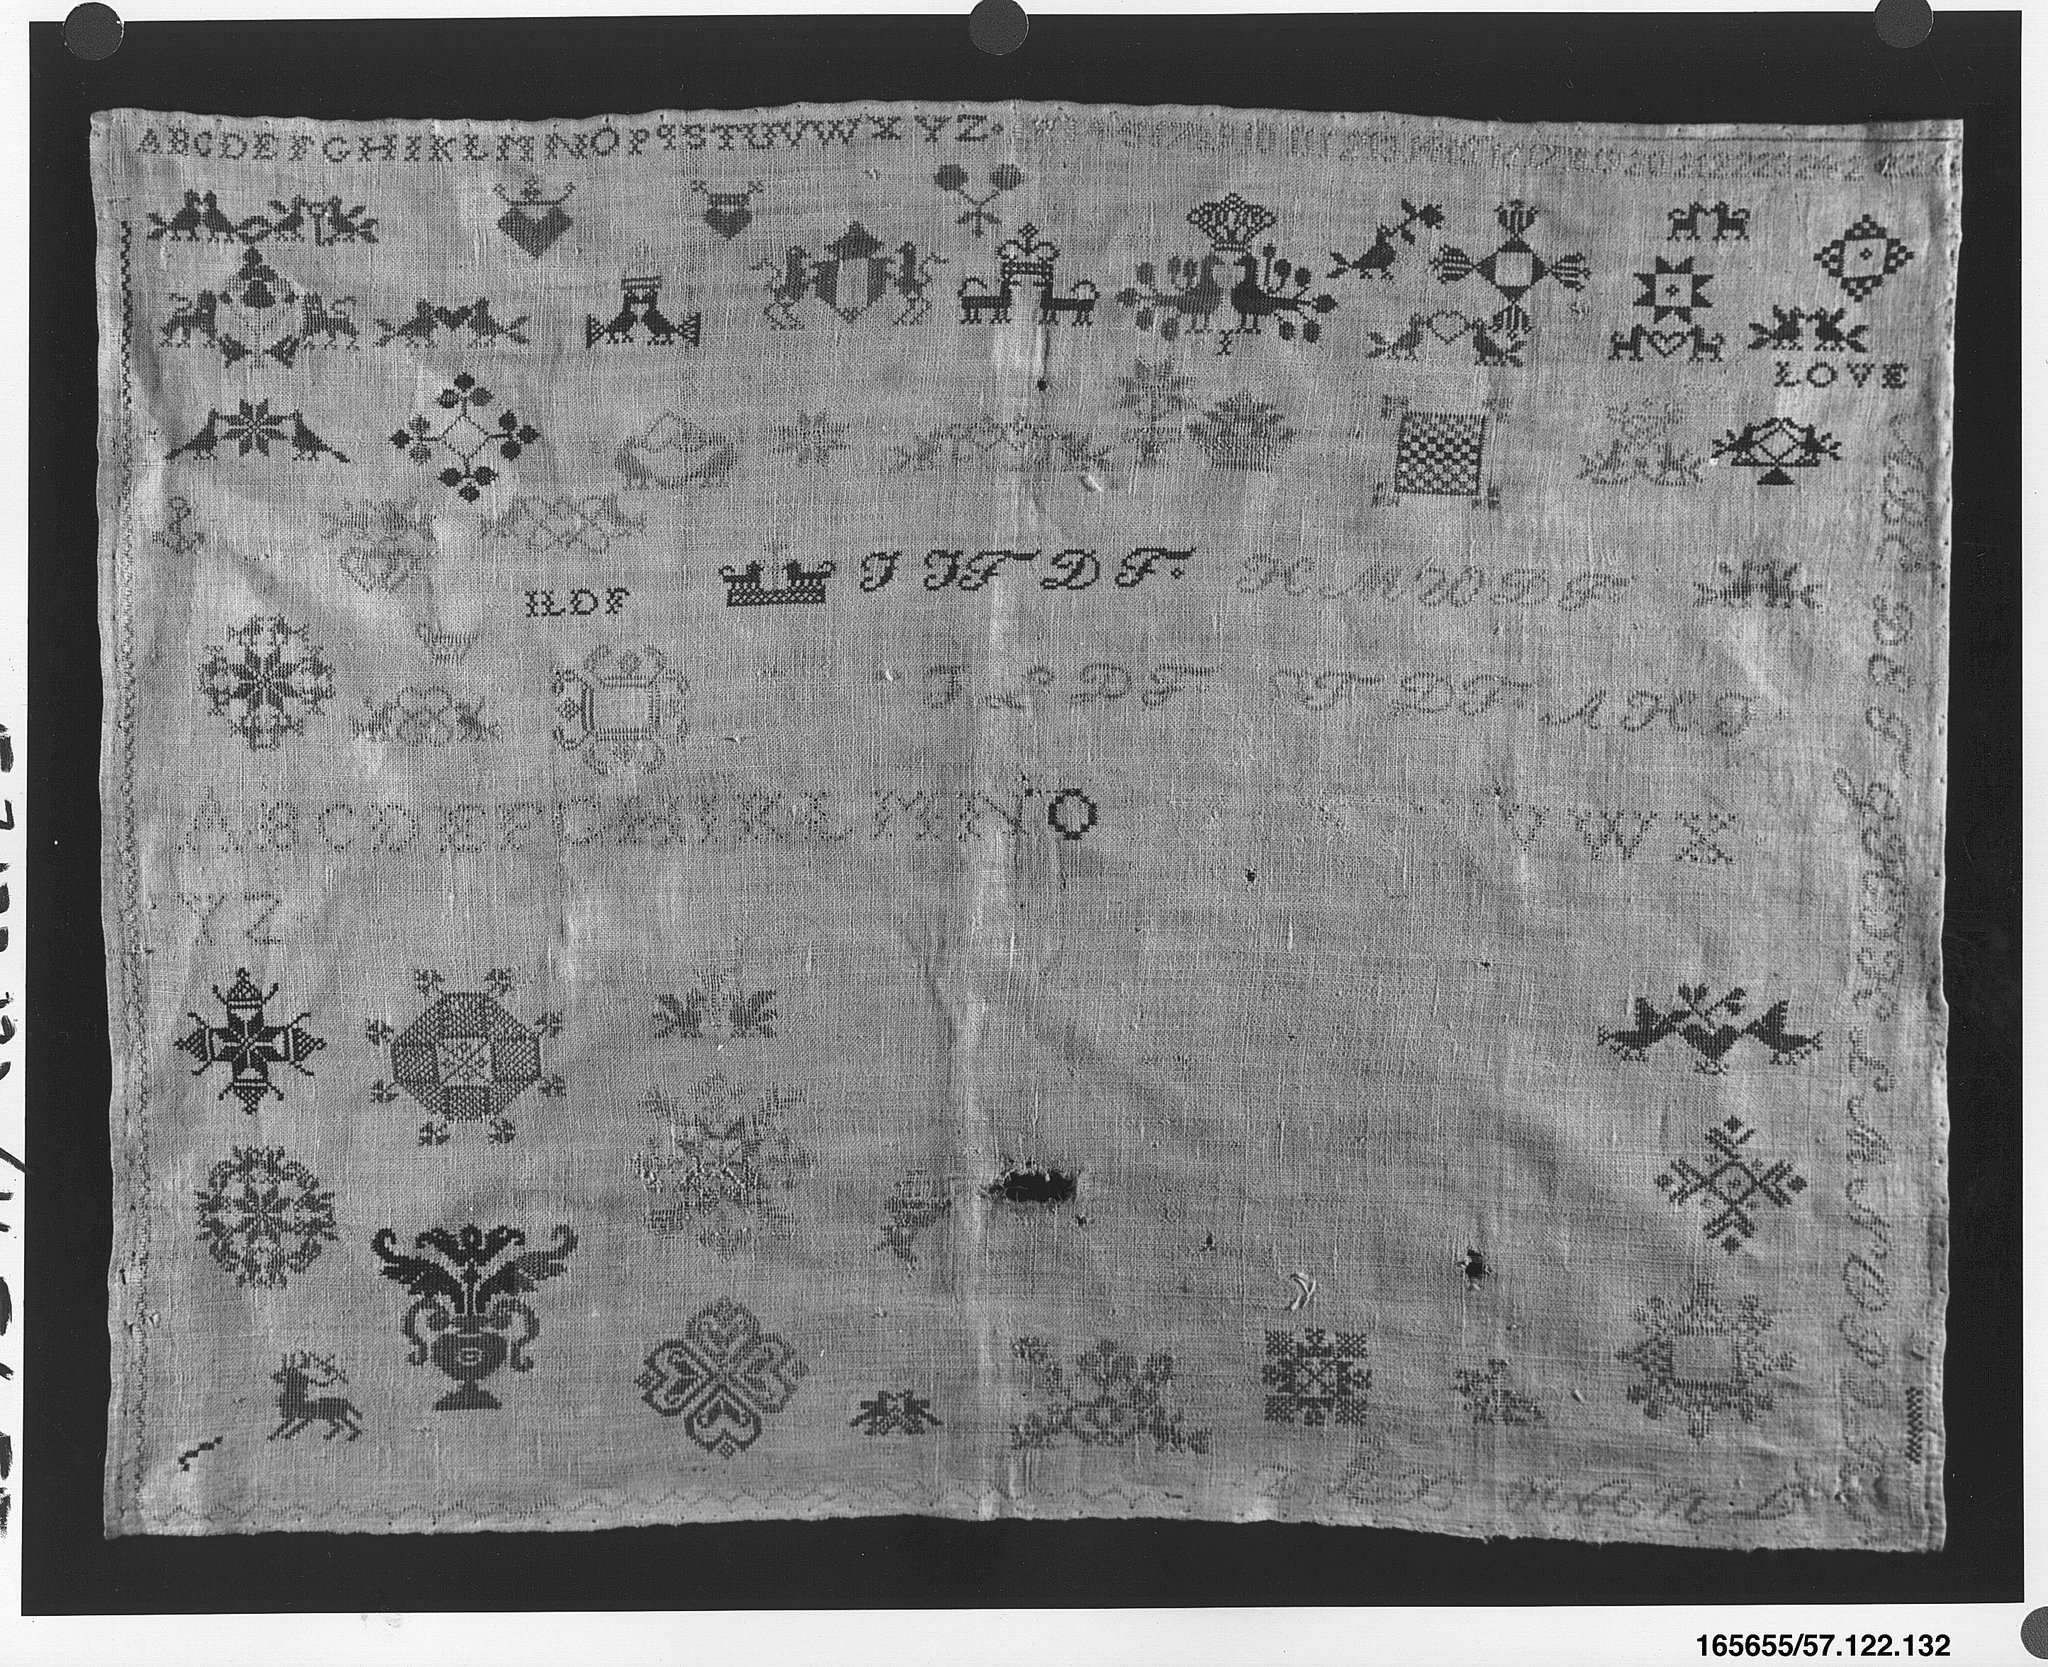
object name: sampler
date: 1801-1900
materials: linen, silk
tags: coat of arms